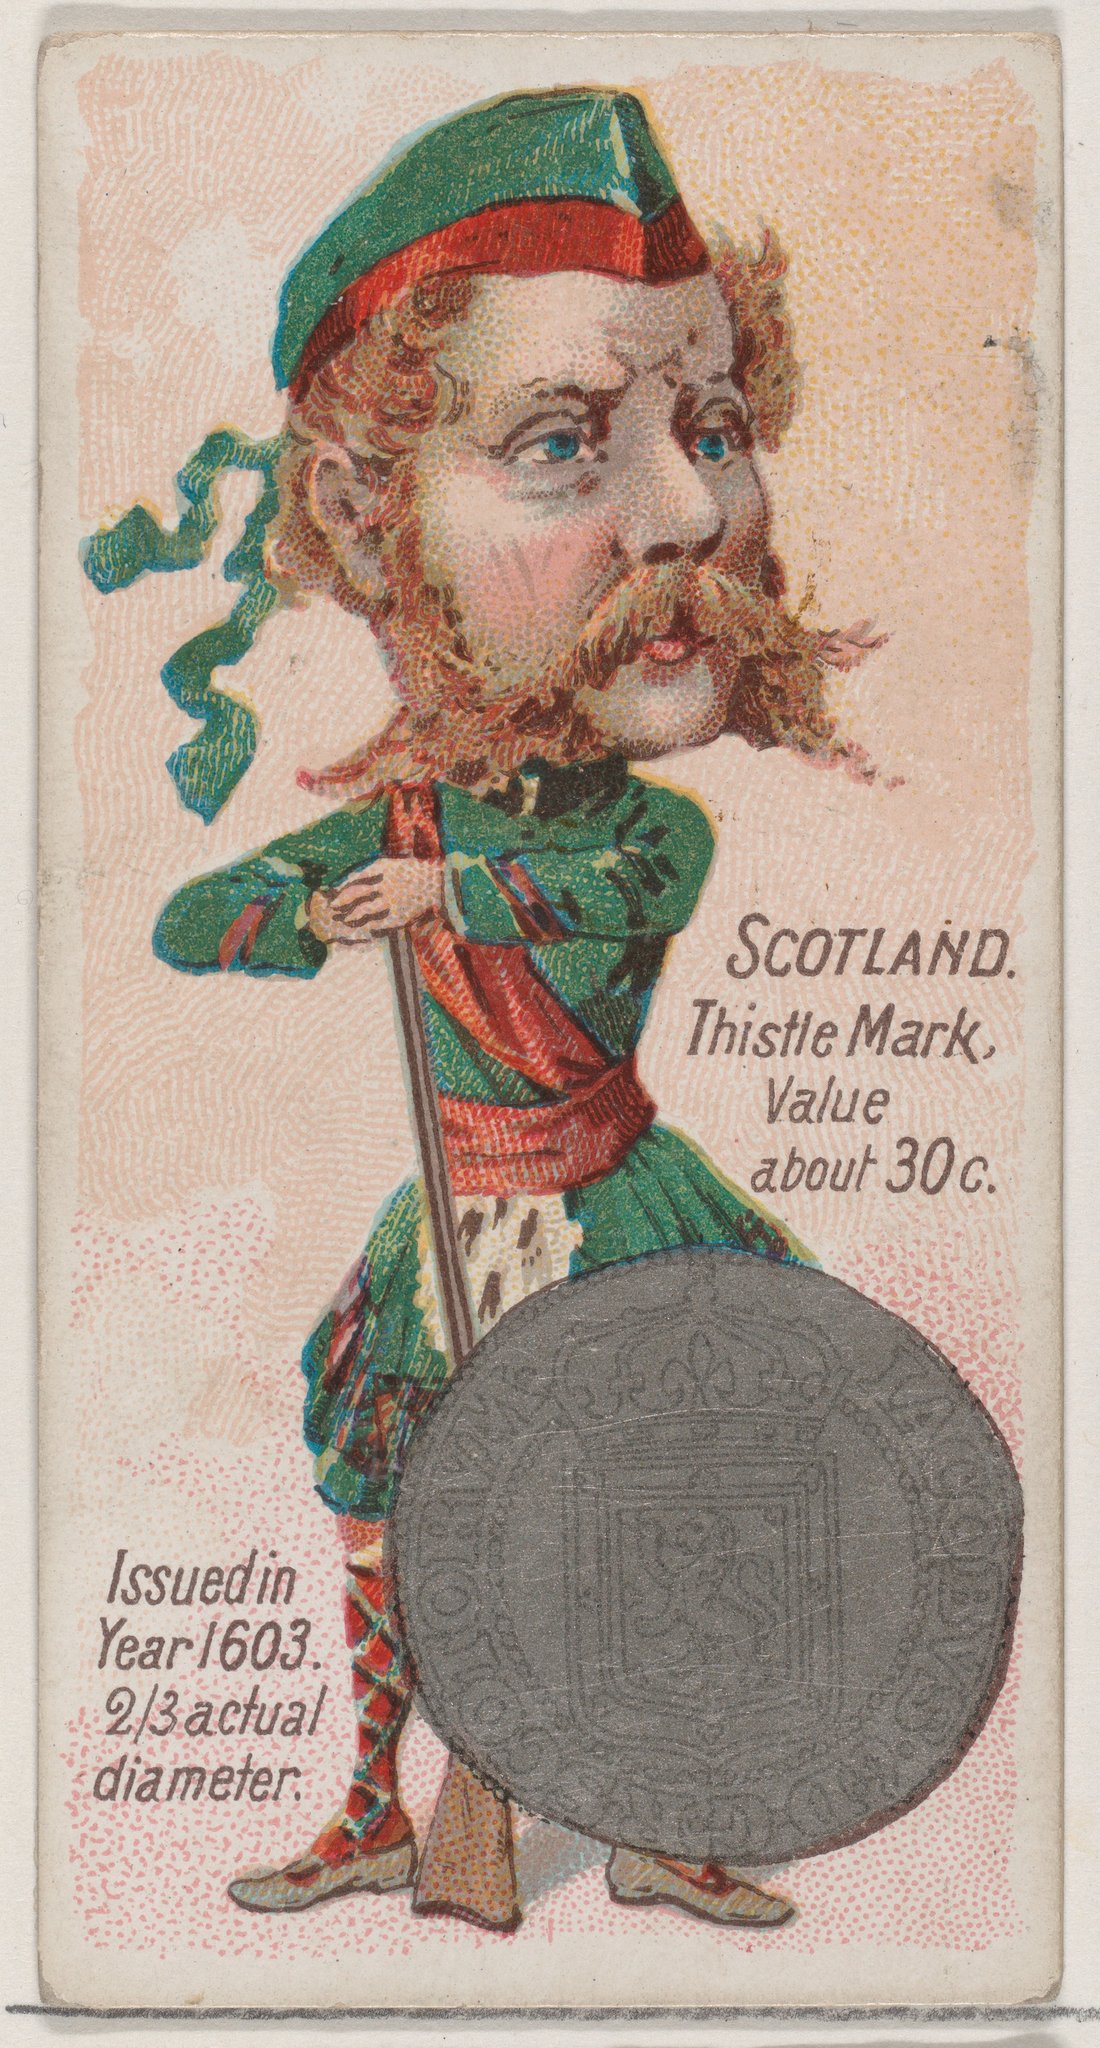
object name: print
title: Scotland, Thistle Mark, from the series Coins of All Nations (N72, variation 2) for Duke brand cigarettes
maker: w. duke, sons & co.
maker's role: publisher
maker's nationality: american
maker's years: 1870-1920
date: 1889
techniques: color lithograph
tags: men,coins